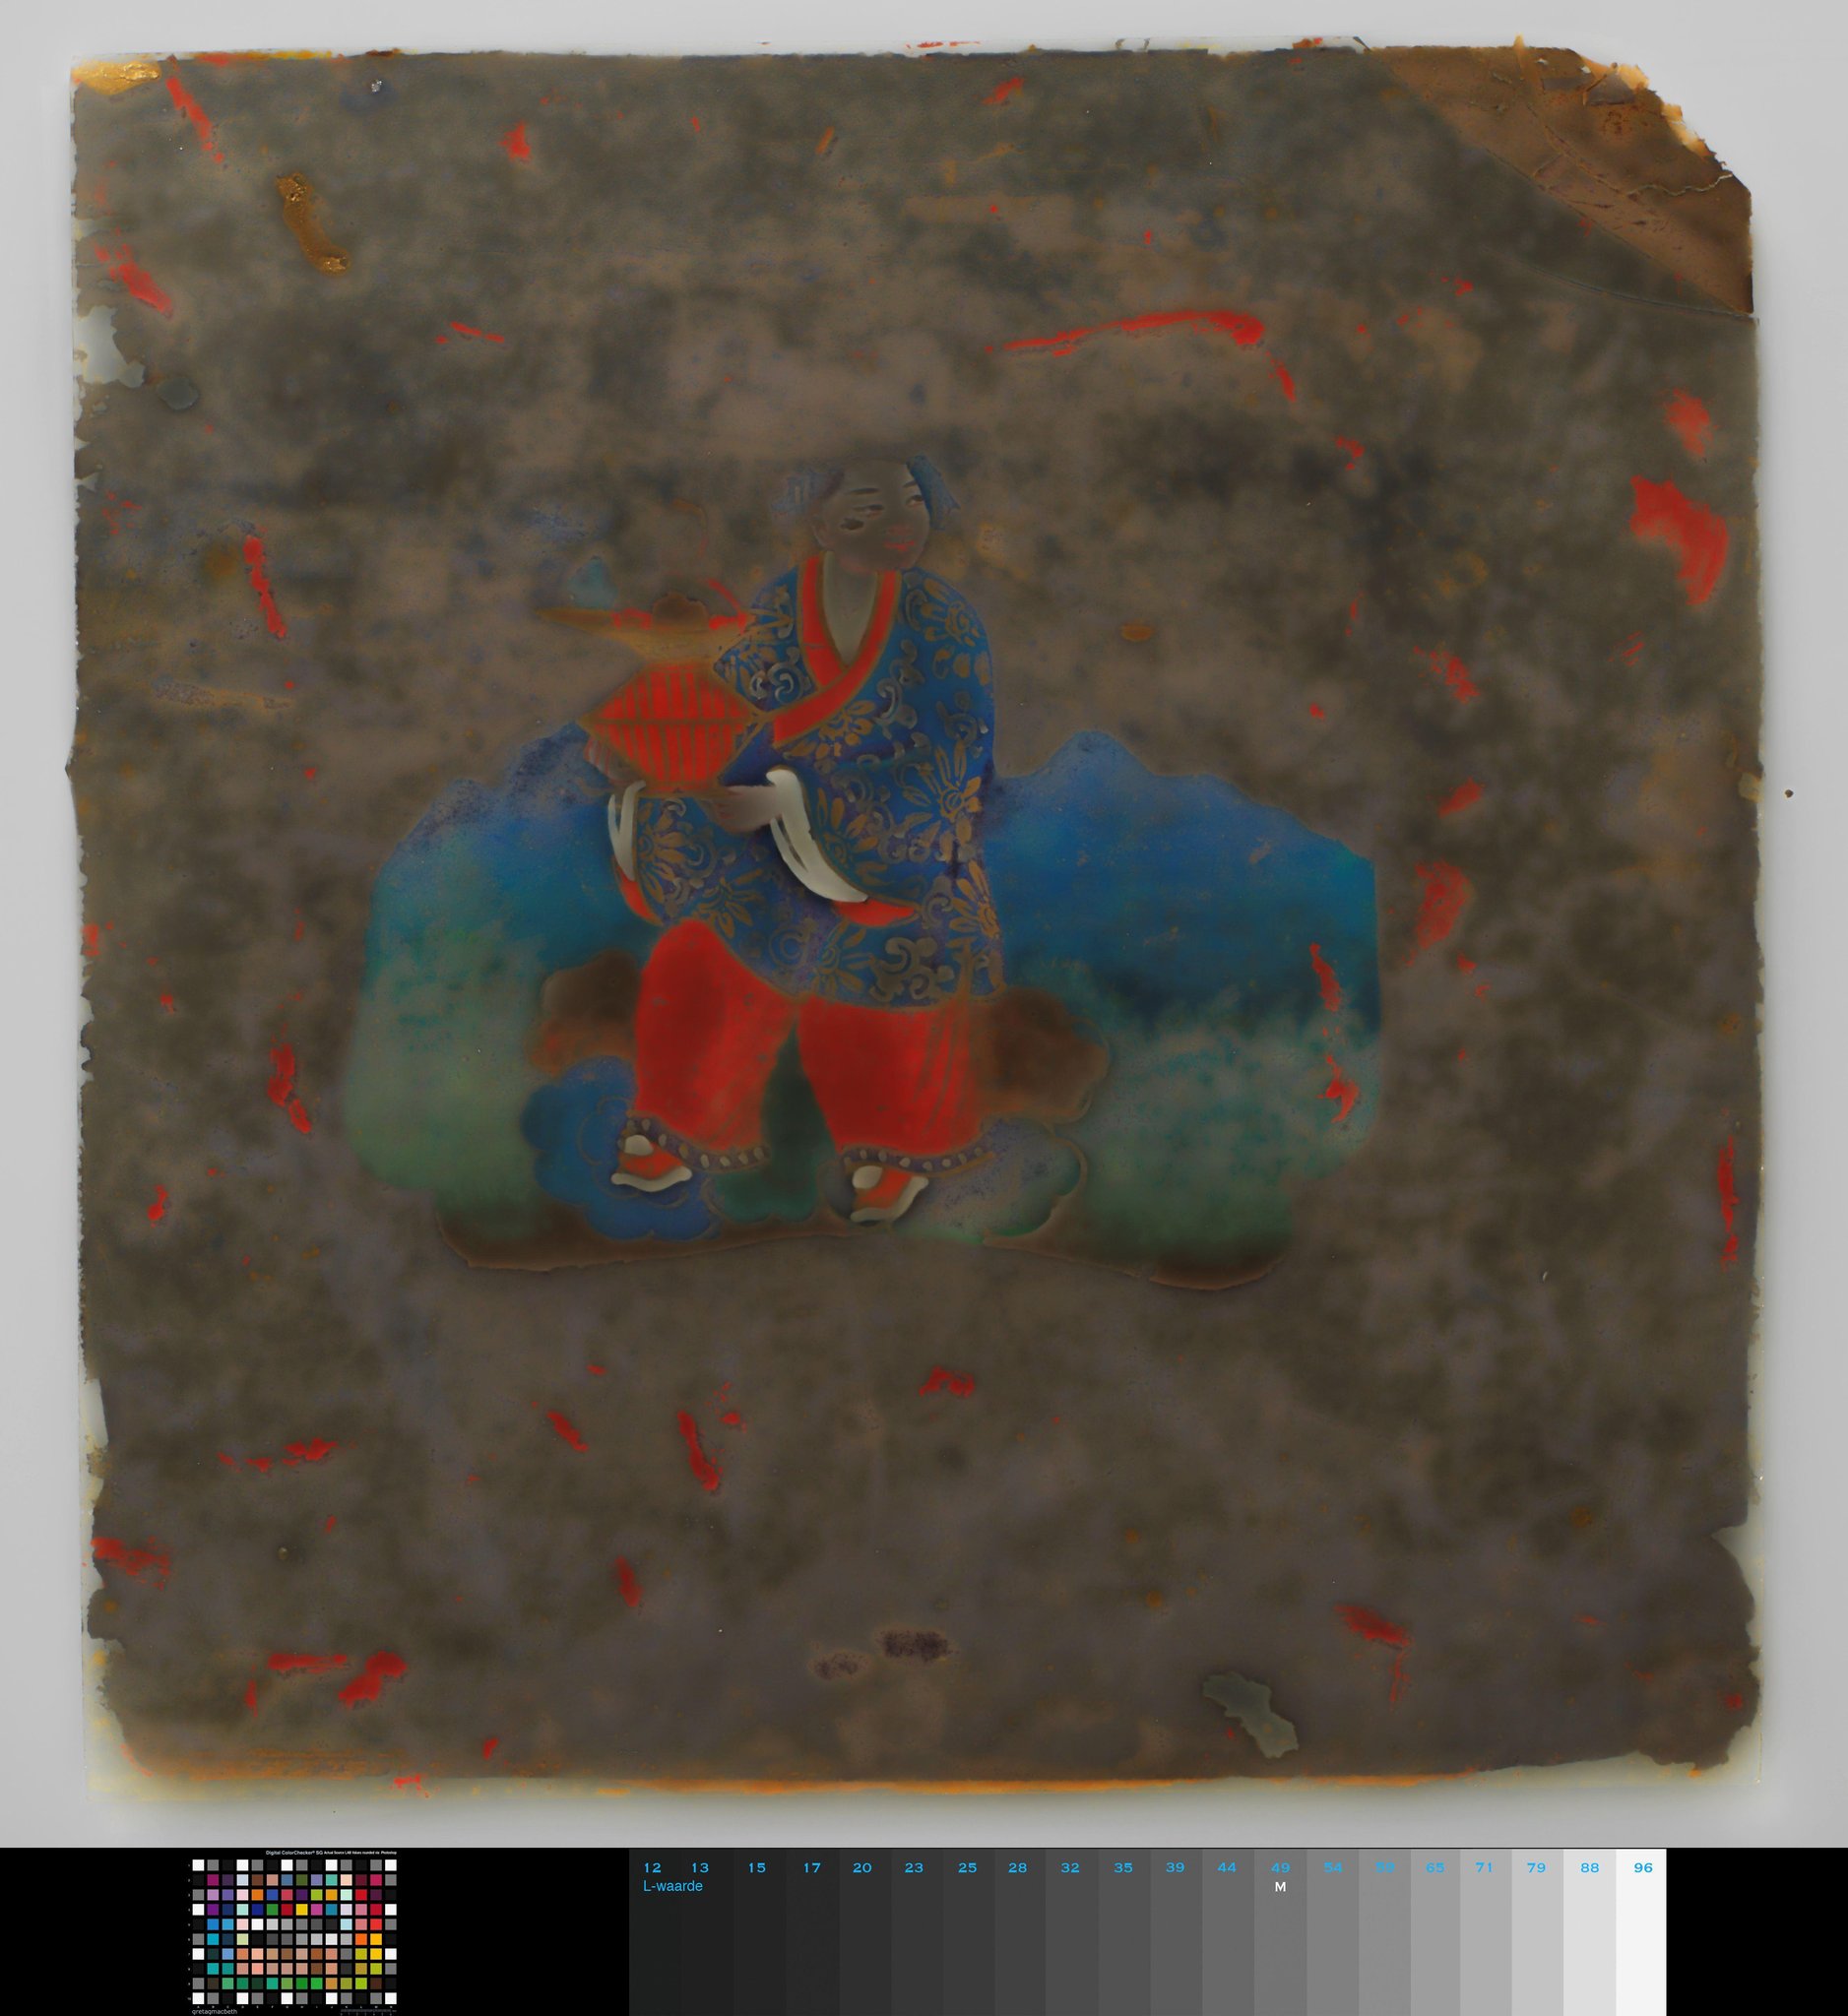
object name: drinking glass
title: Glaspaneel met Chinese voorstelling (vrouw) van tempelstuk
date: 1600-1650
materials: glass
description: Glaspaneel met Chinese voorstelling van tempelstuk.